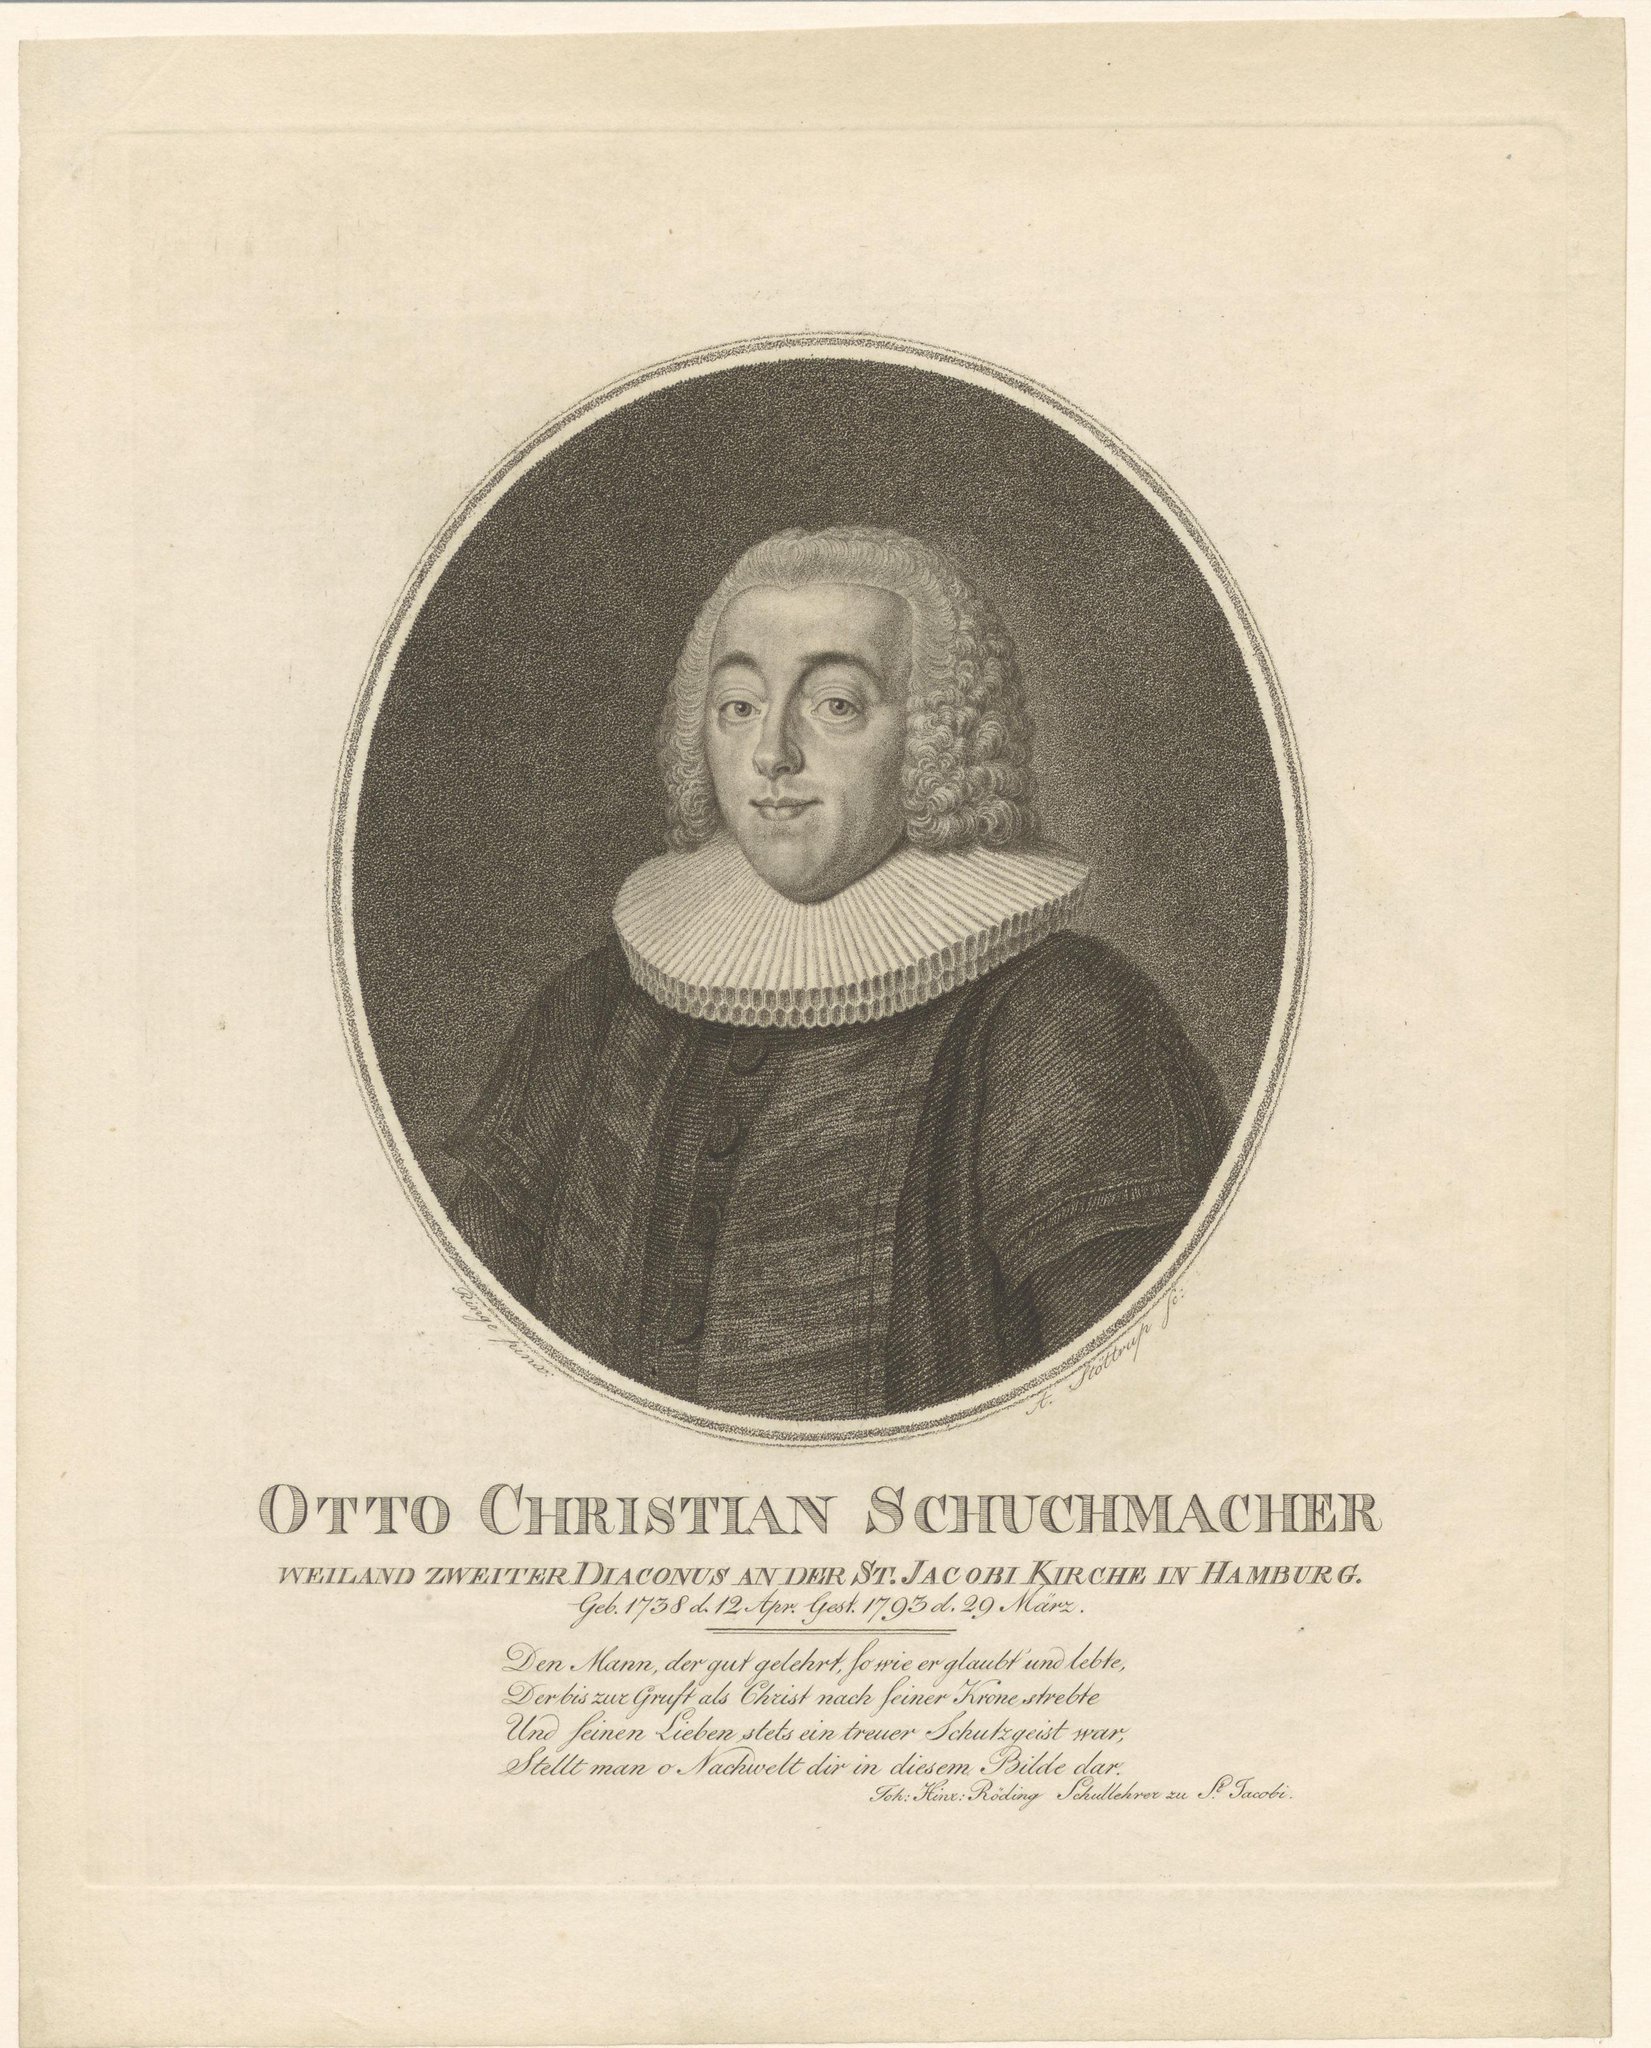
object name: print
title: Portret van Otto Christian Schuchmacher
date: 1793-1812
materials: paper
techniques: engraving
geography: hamburg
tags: historical persons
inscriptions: collector's mark: Lugt 2228